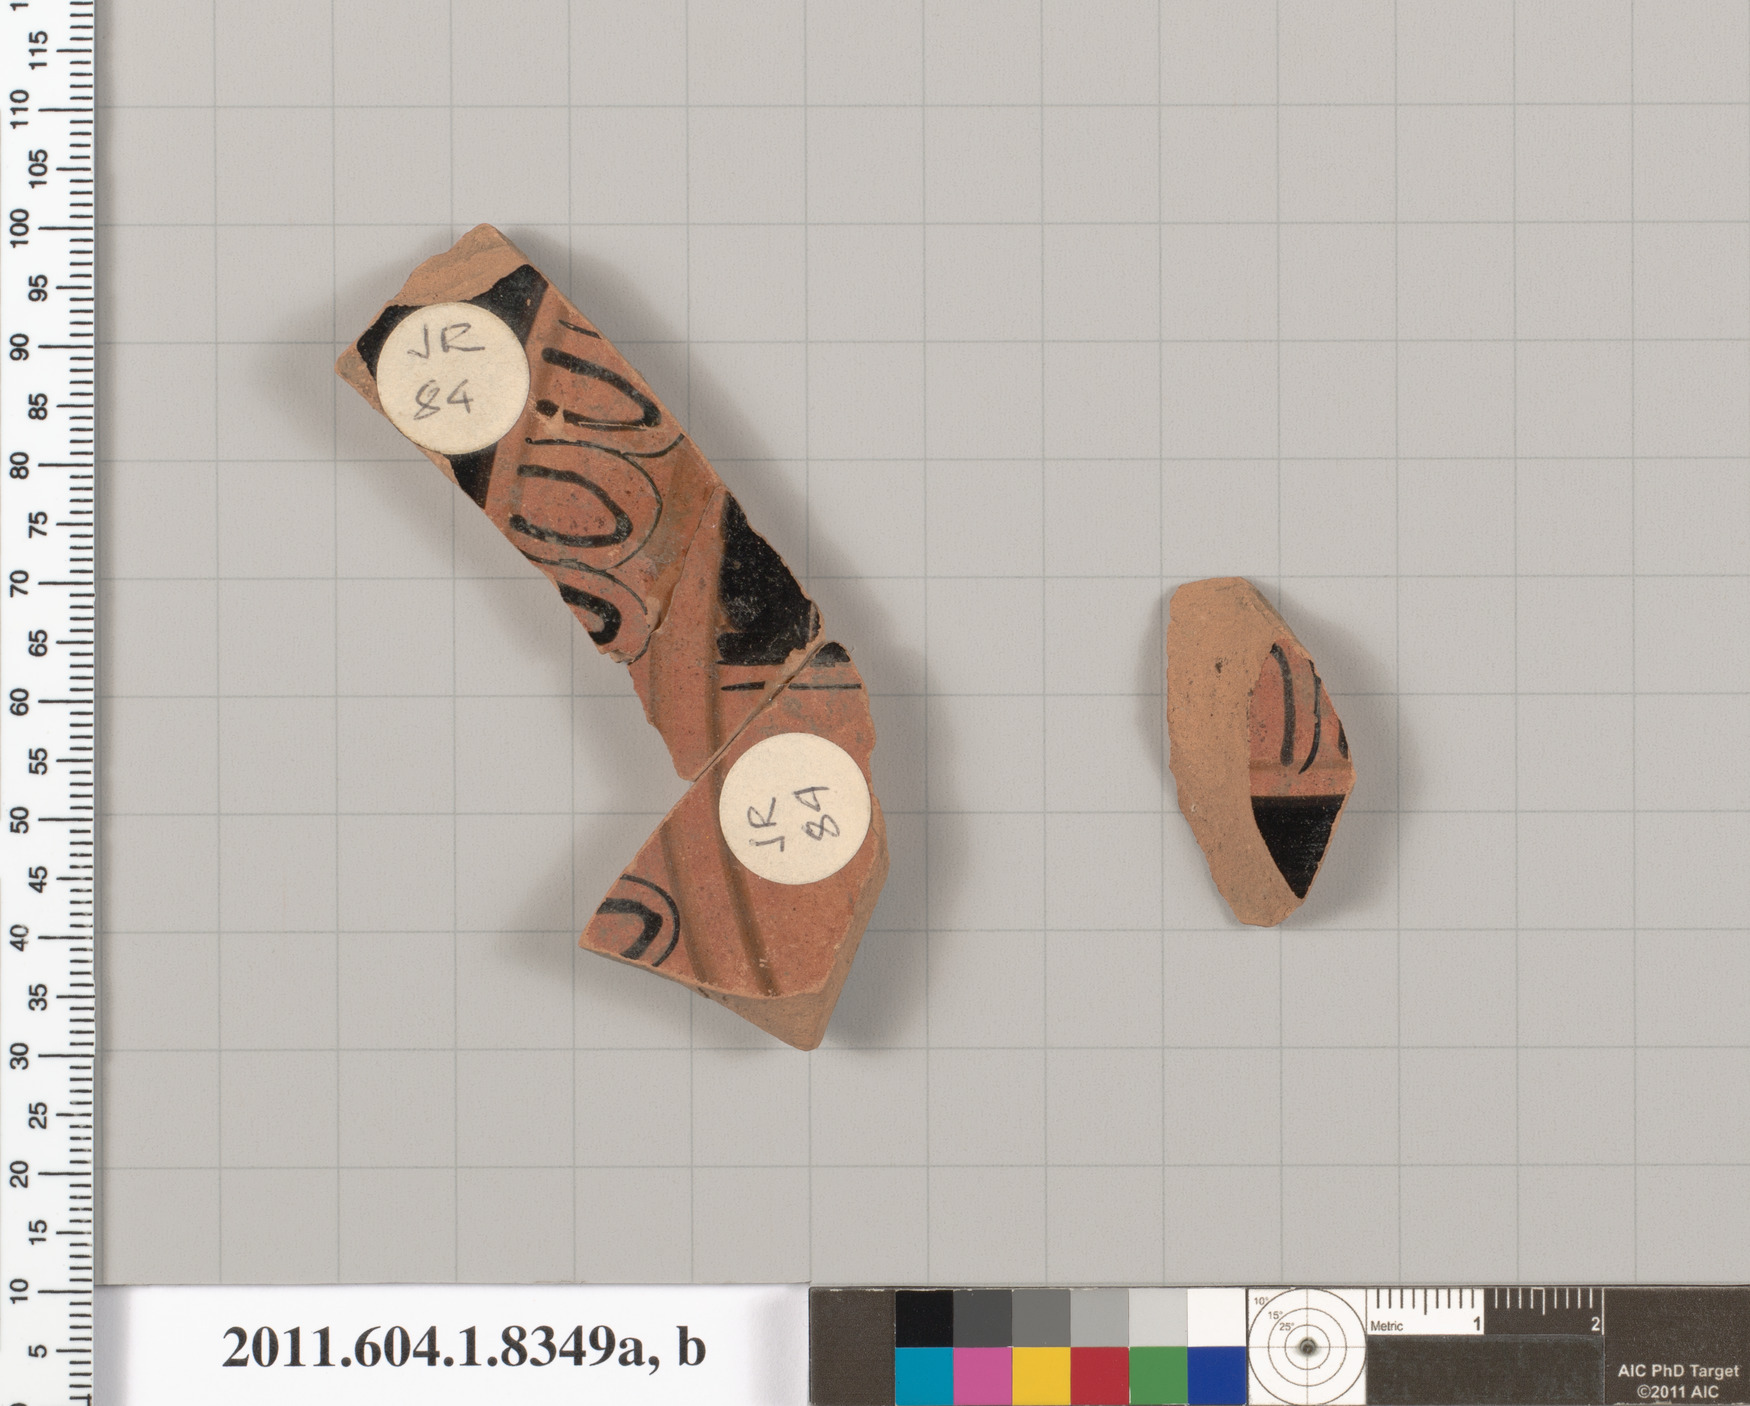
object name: kylix fragment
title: Terracotta fragments of a kylix (drinking cup)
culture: greek, attic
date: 351-375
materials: terracotta